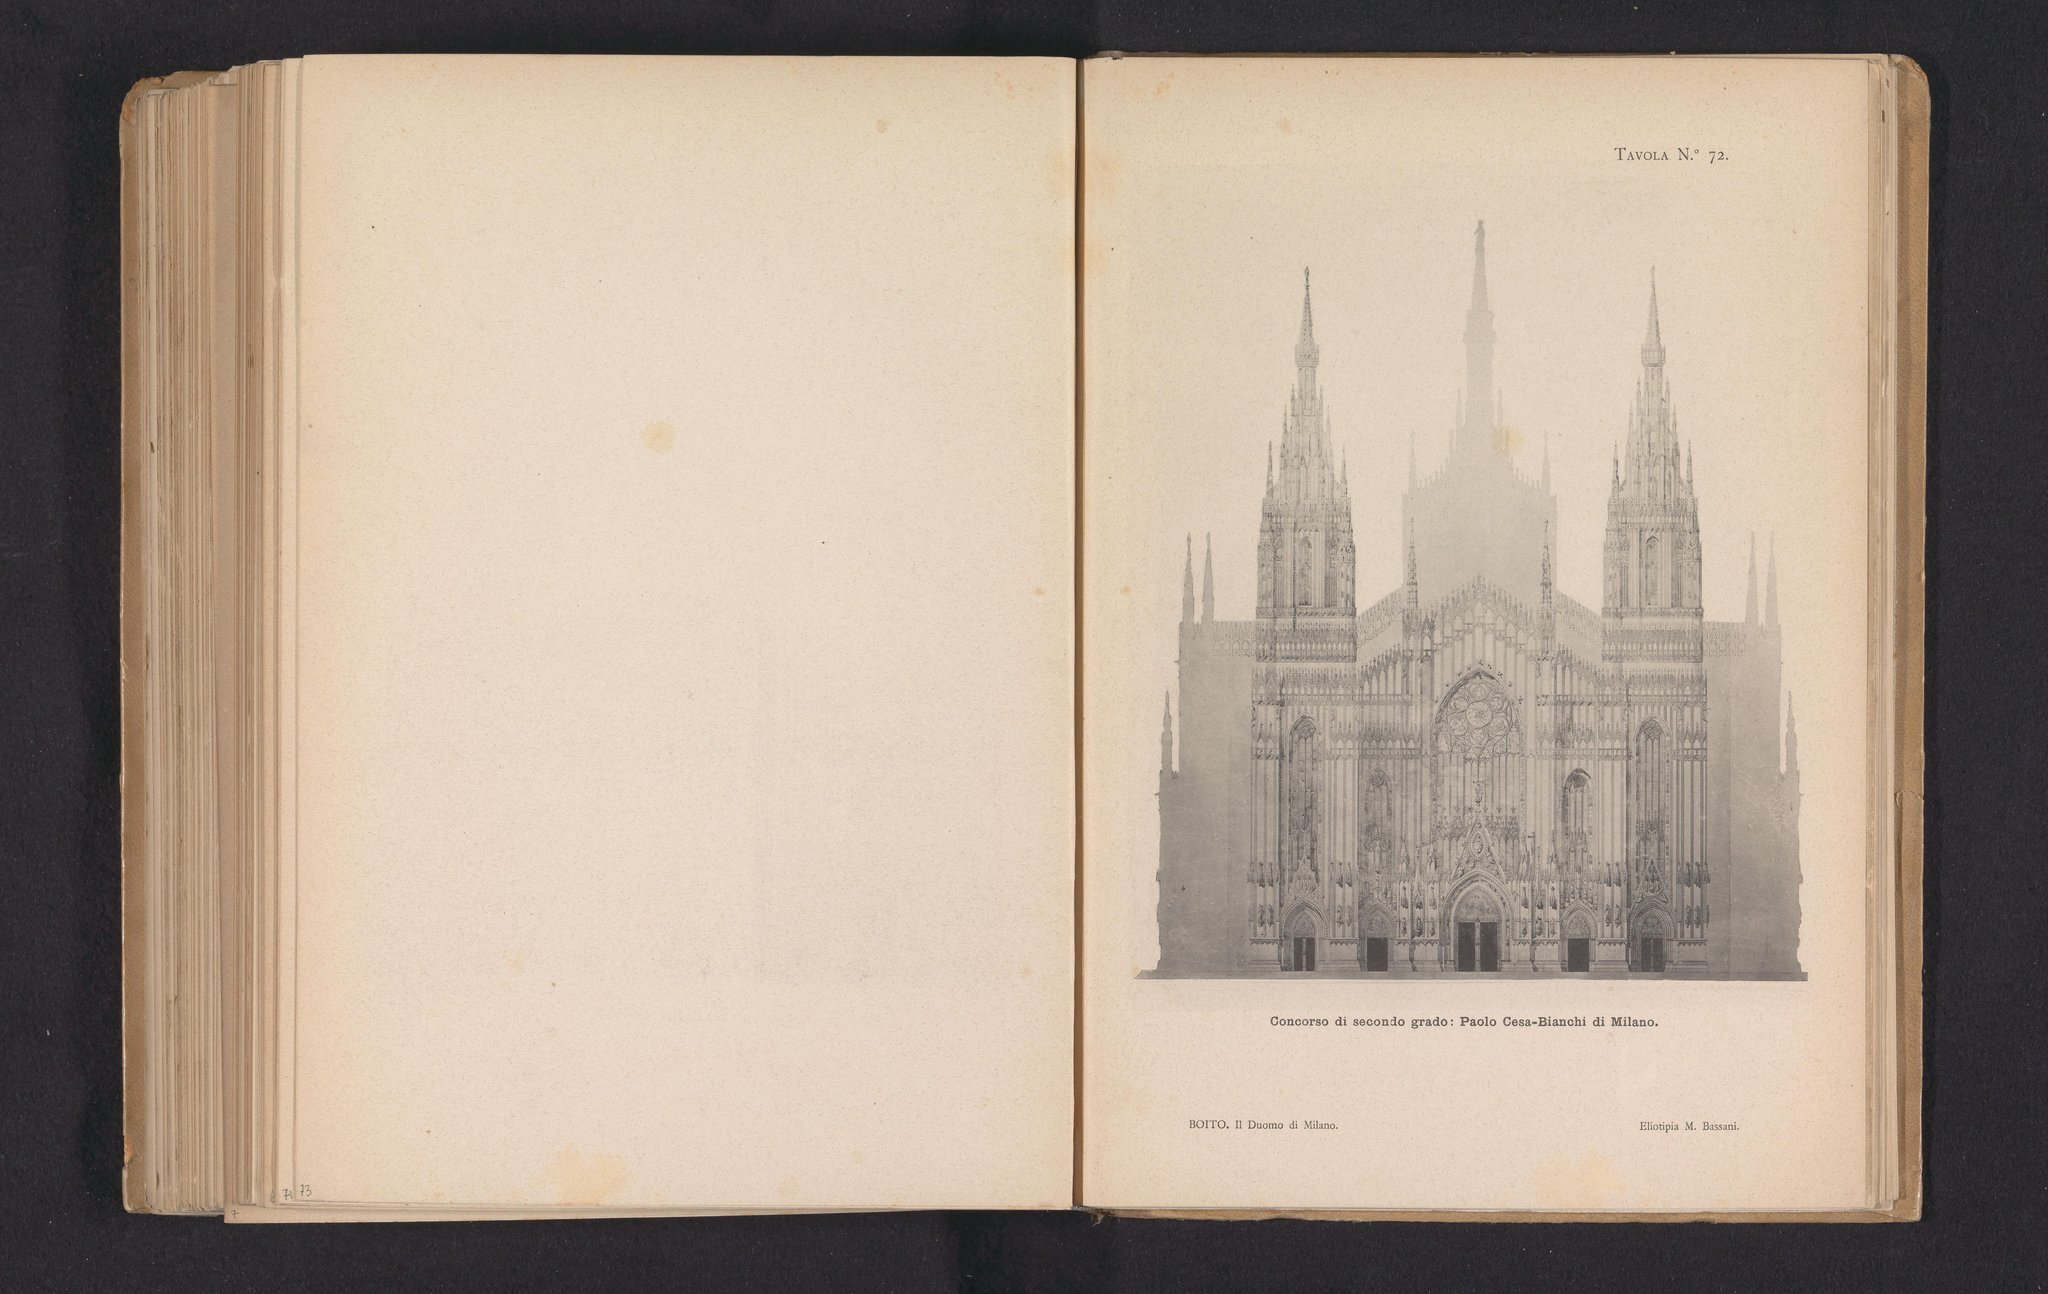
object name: page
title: Concorso di secondo grado : Paolo Ces-Bianchi di Milano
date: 1886-1889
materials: paper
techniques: photograph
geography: milan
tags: drawing, sketch, parts of church exterior and annexes: façade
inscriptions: number: ‘Tavola No. 72.’